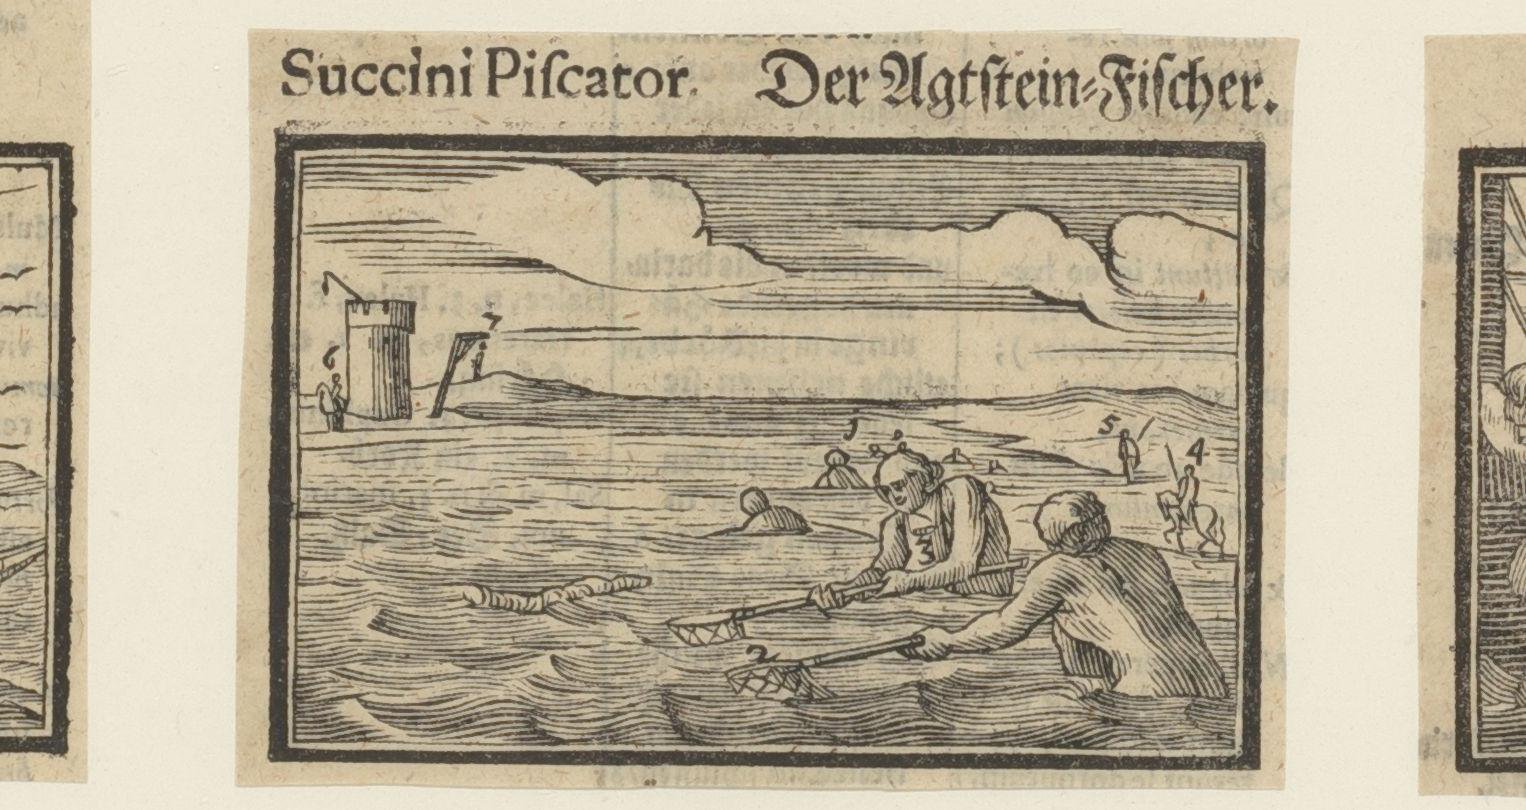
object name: book illustration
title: Succini Piscator. Der Agtstein-Fischer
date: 1719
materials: paper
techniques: letterpress printing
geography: nuremberg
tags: amber (fossil resin), fisherman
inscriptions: collector's mark: Lugt 1641, stamp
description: Barnsteenvissers slepen bij laag water met hun netten over de zeebodem. Om hun nek een tas voor de gevonden barnsteen. Op het strand een toren en wachten de bewakers van de gevonden barnsteen. Onderwerpsrubrieken binnen de Atlas Zeden en Gewoonten: Handel, Nijverheid en Verkeer, Beroep en bedrijf, Complete suites.